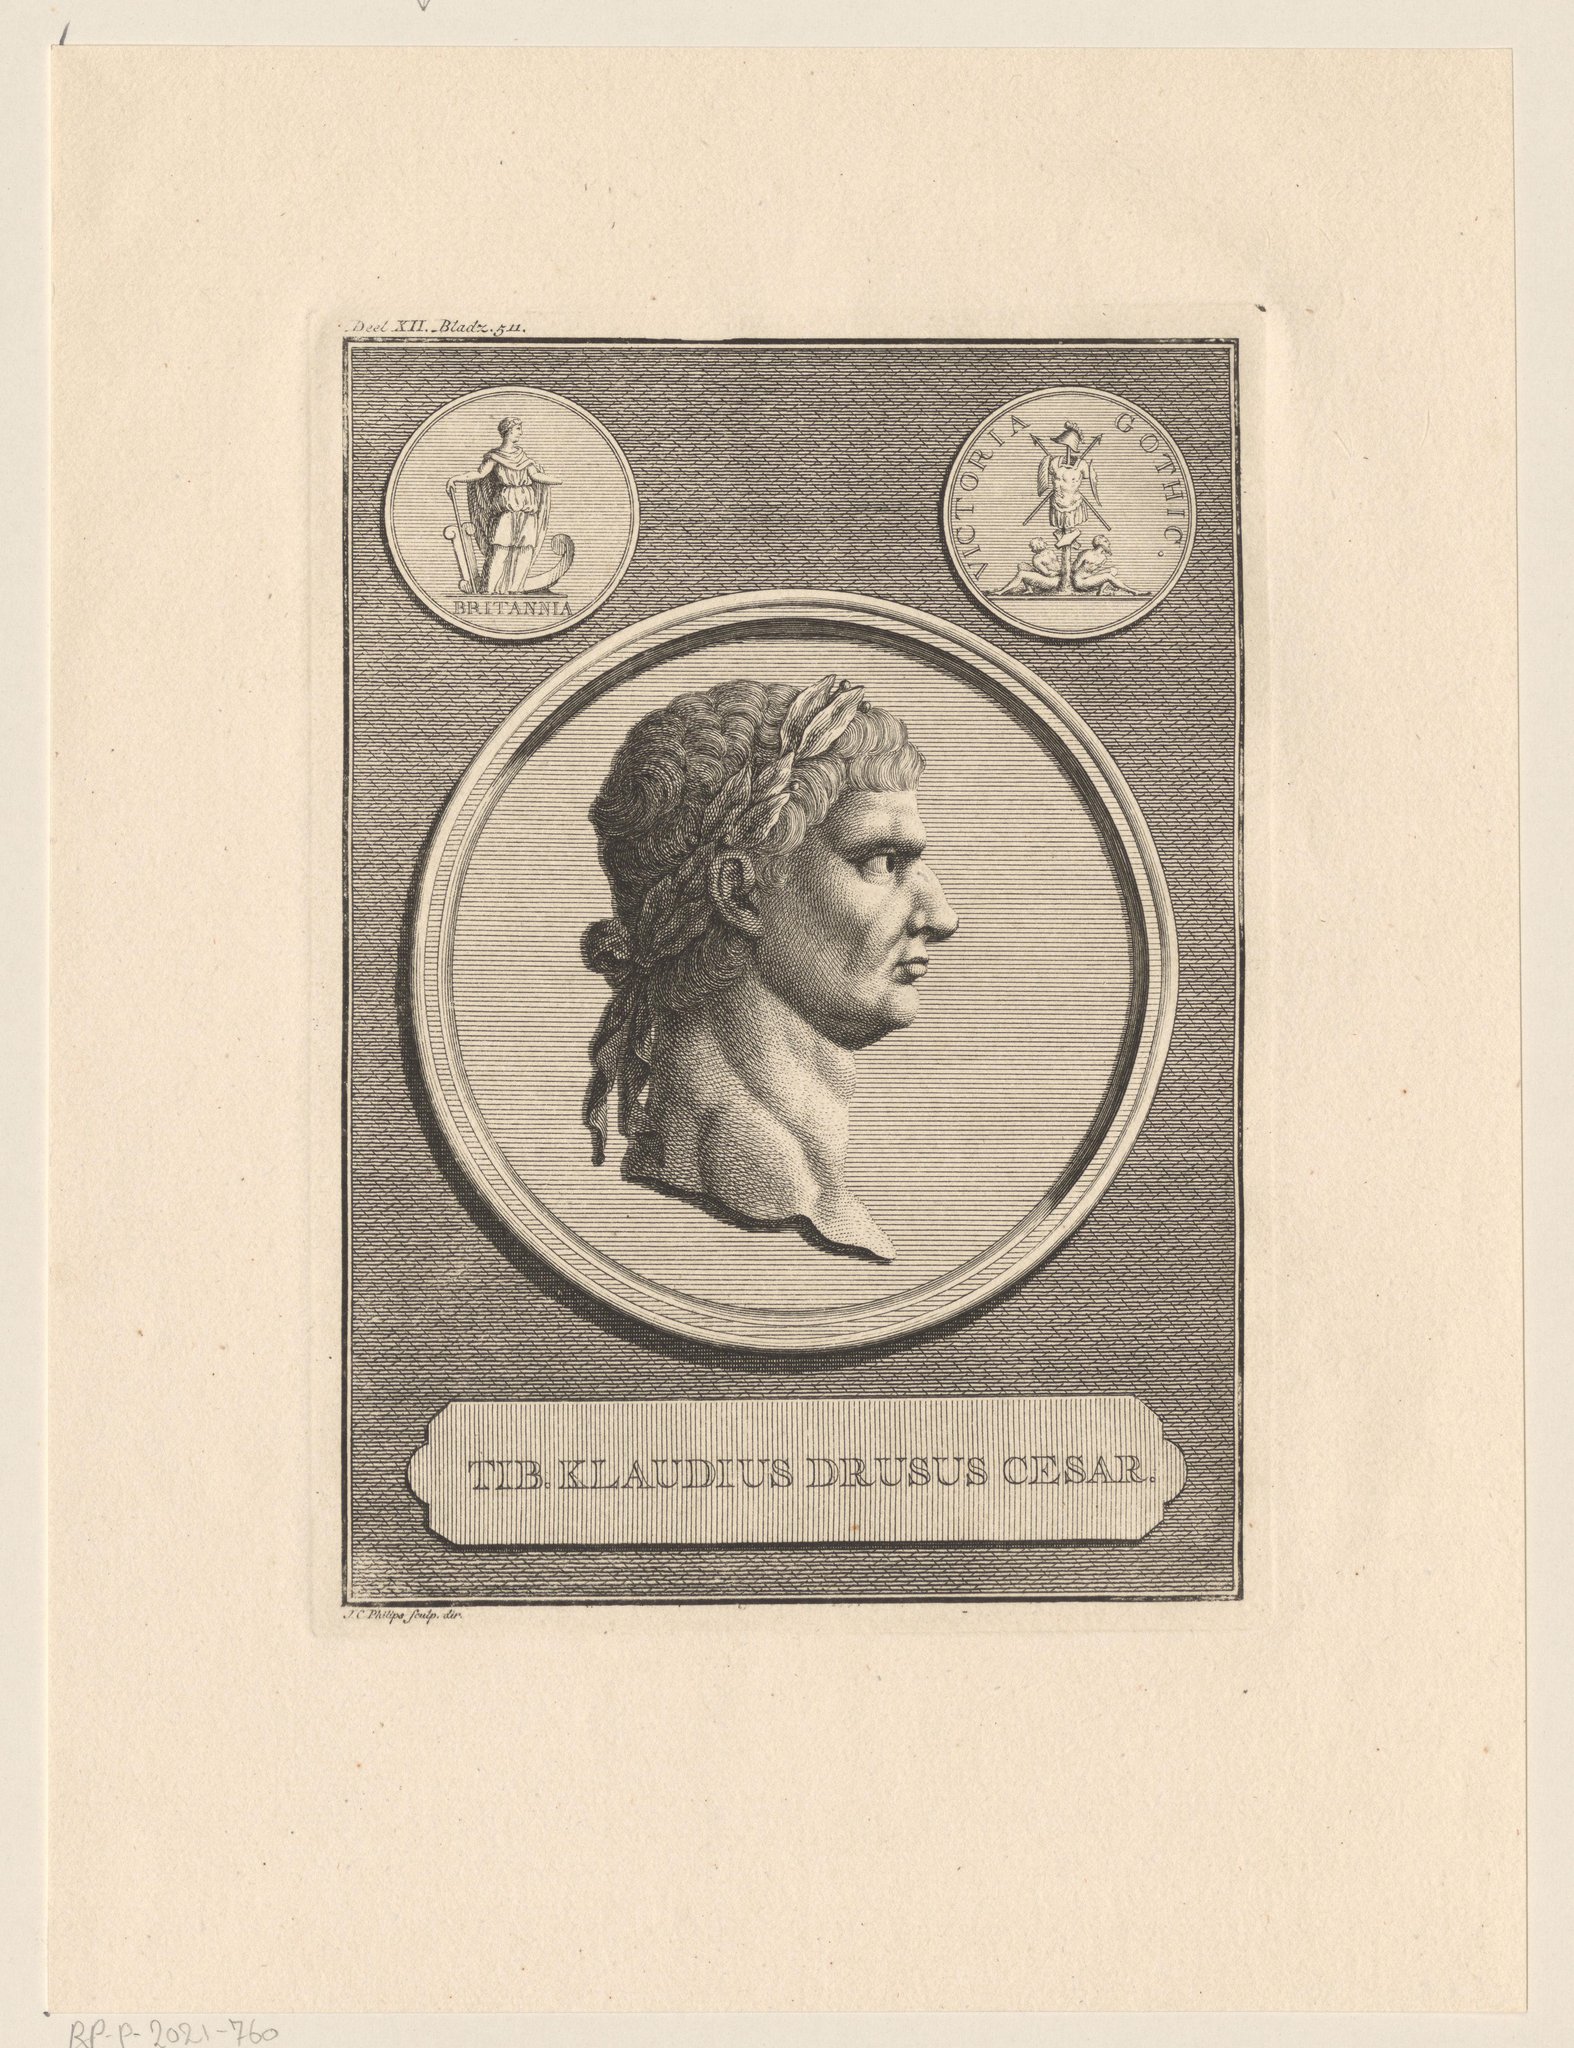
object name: print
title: Portret van Claudius I, keizer van het Romeinse Rijk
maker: jan caspar philips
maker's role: draughtsman, print maker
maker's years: 1700-1775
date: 1730-1775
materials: paper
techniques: engraving, etching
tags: historical persons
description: Linksboven genummerd: Deel XII. Bladz. 511.